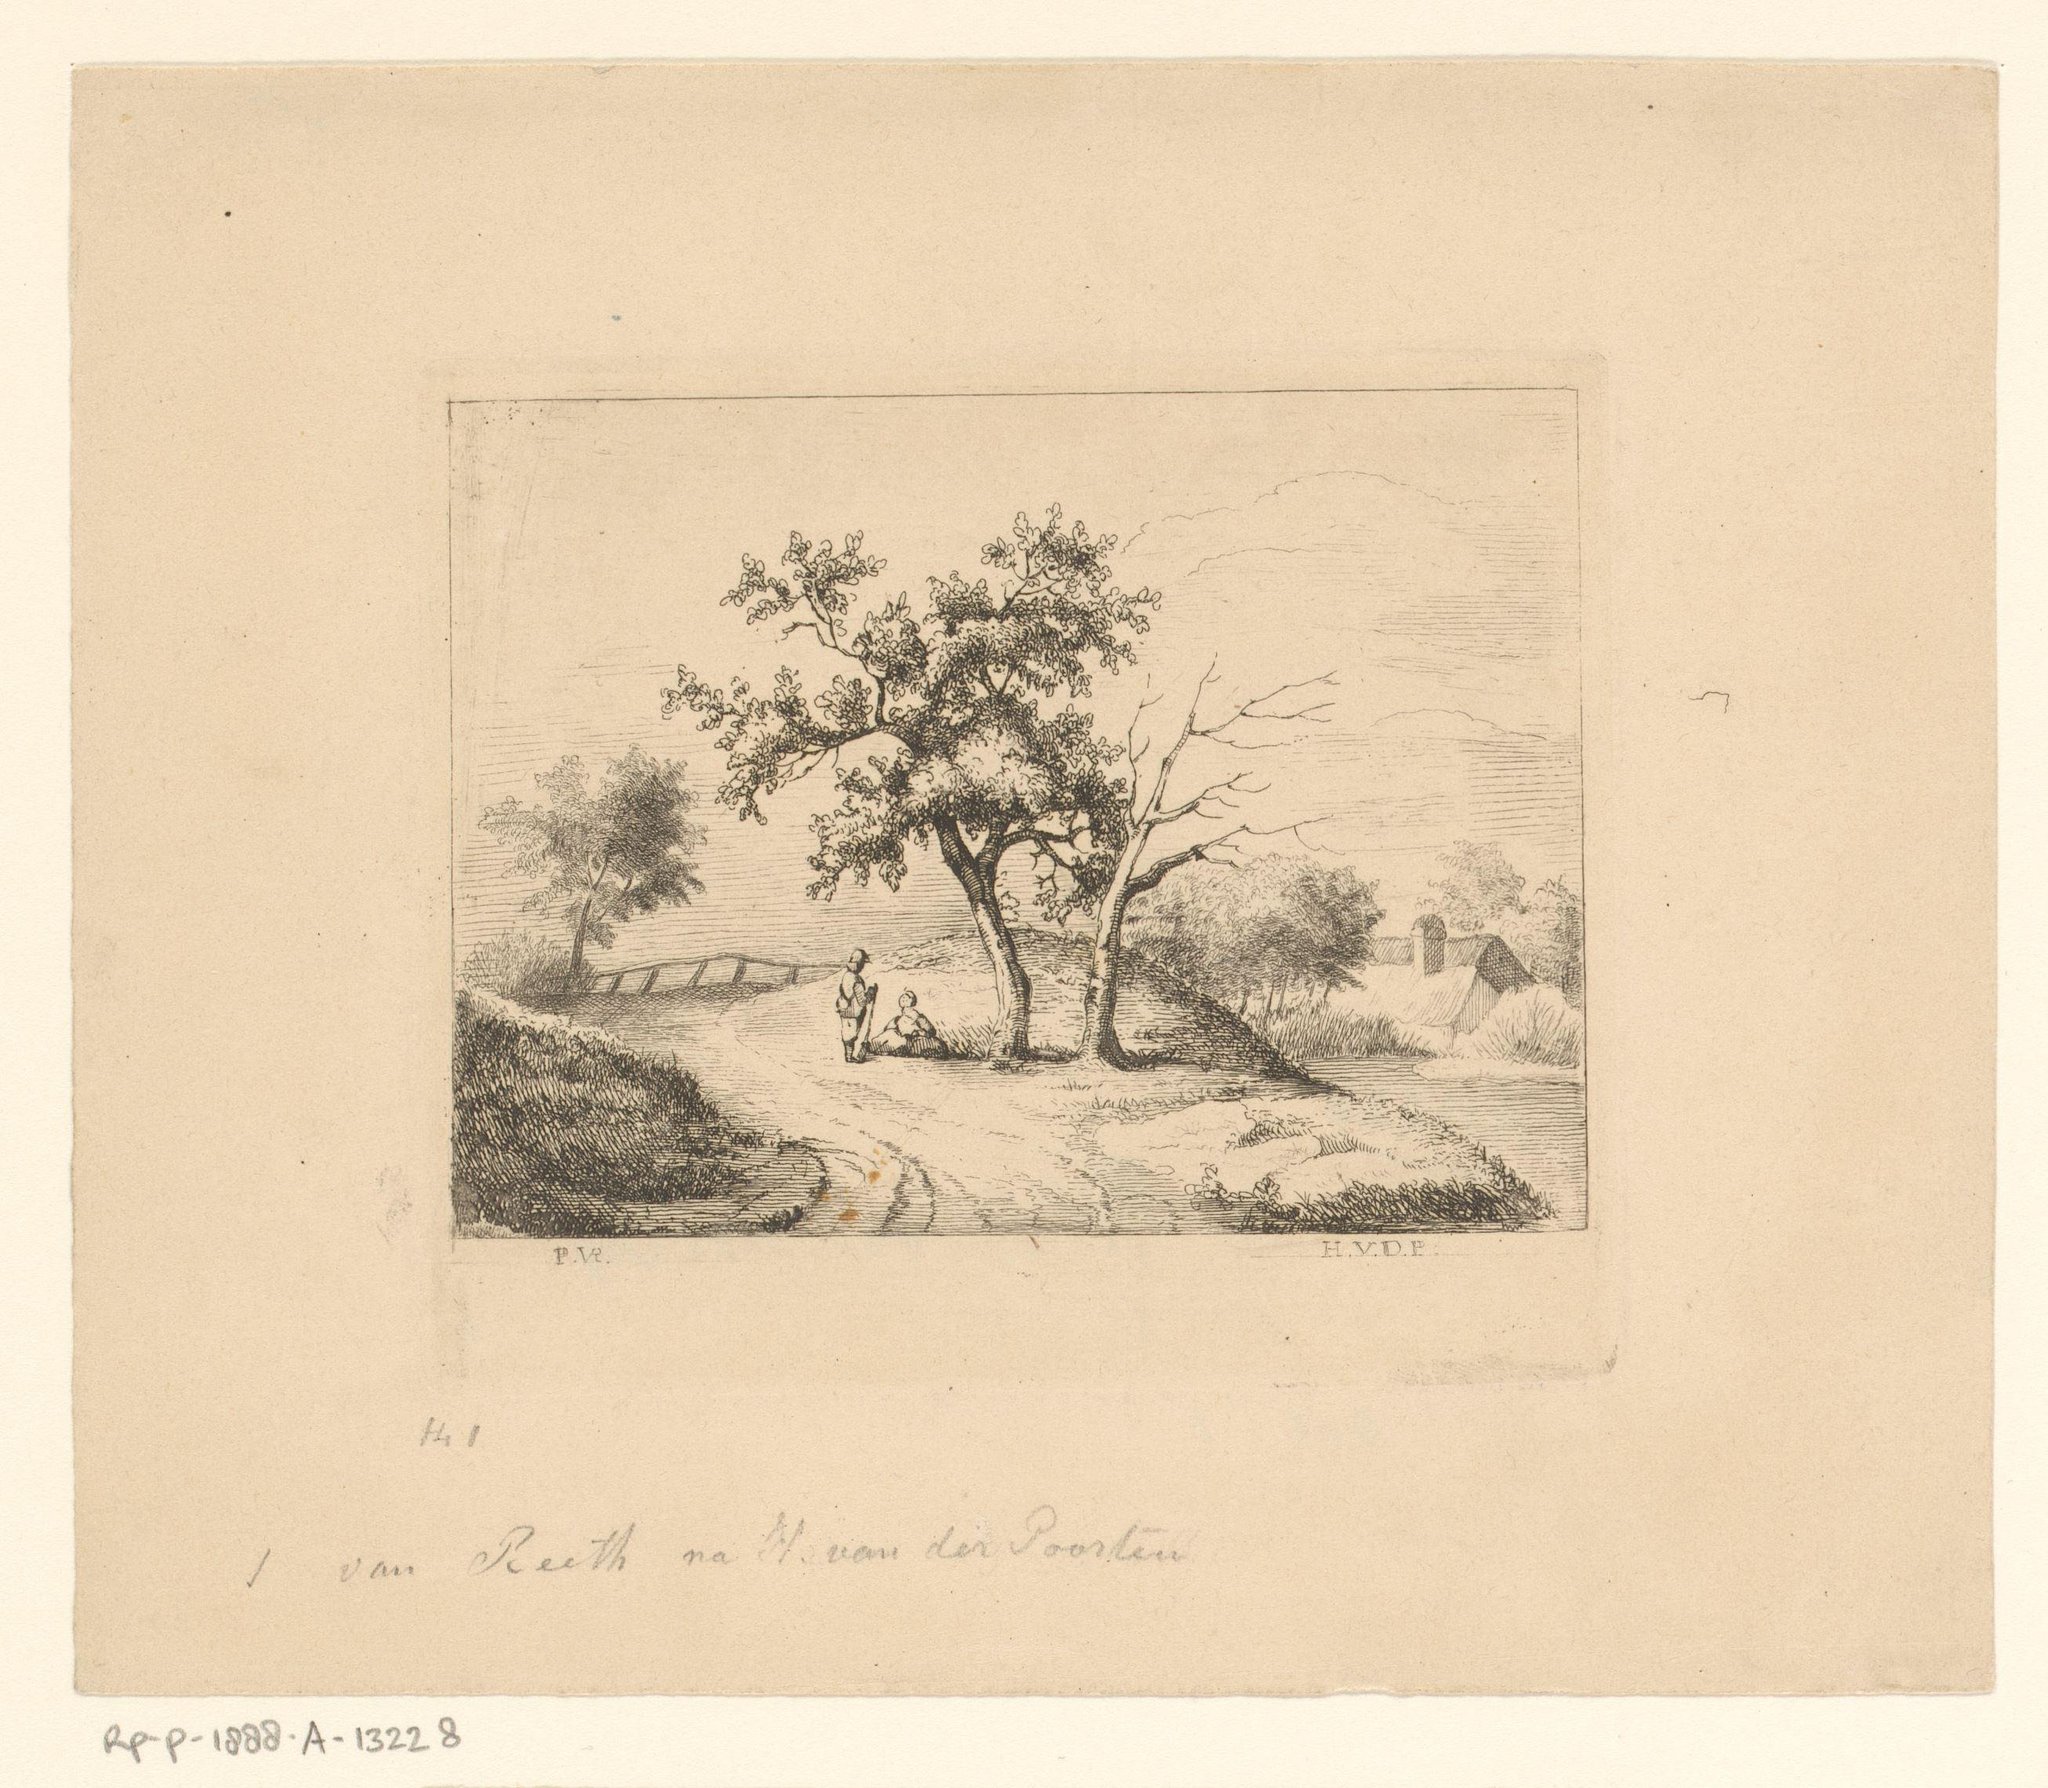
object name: print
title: Landschap met twee figuren op een weg onder een boom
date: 1799-1866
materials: paper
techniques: etching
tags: landscapes (+ landscape with figures, staffage)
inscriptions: collector's mark: Lugt 2228